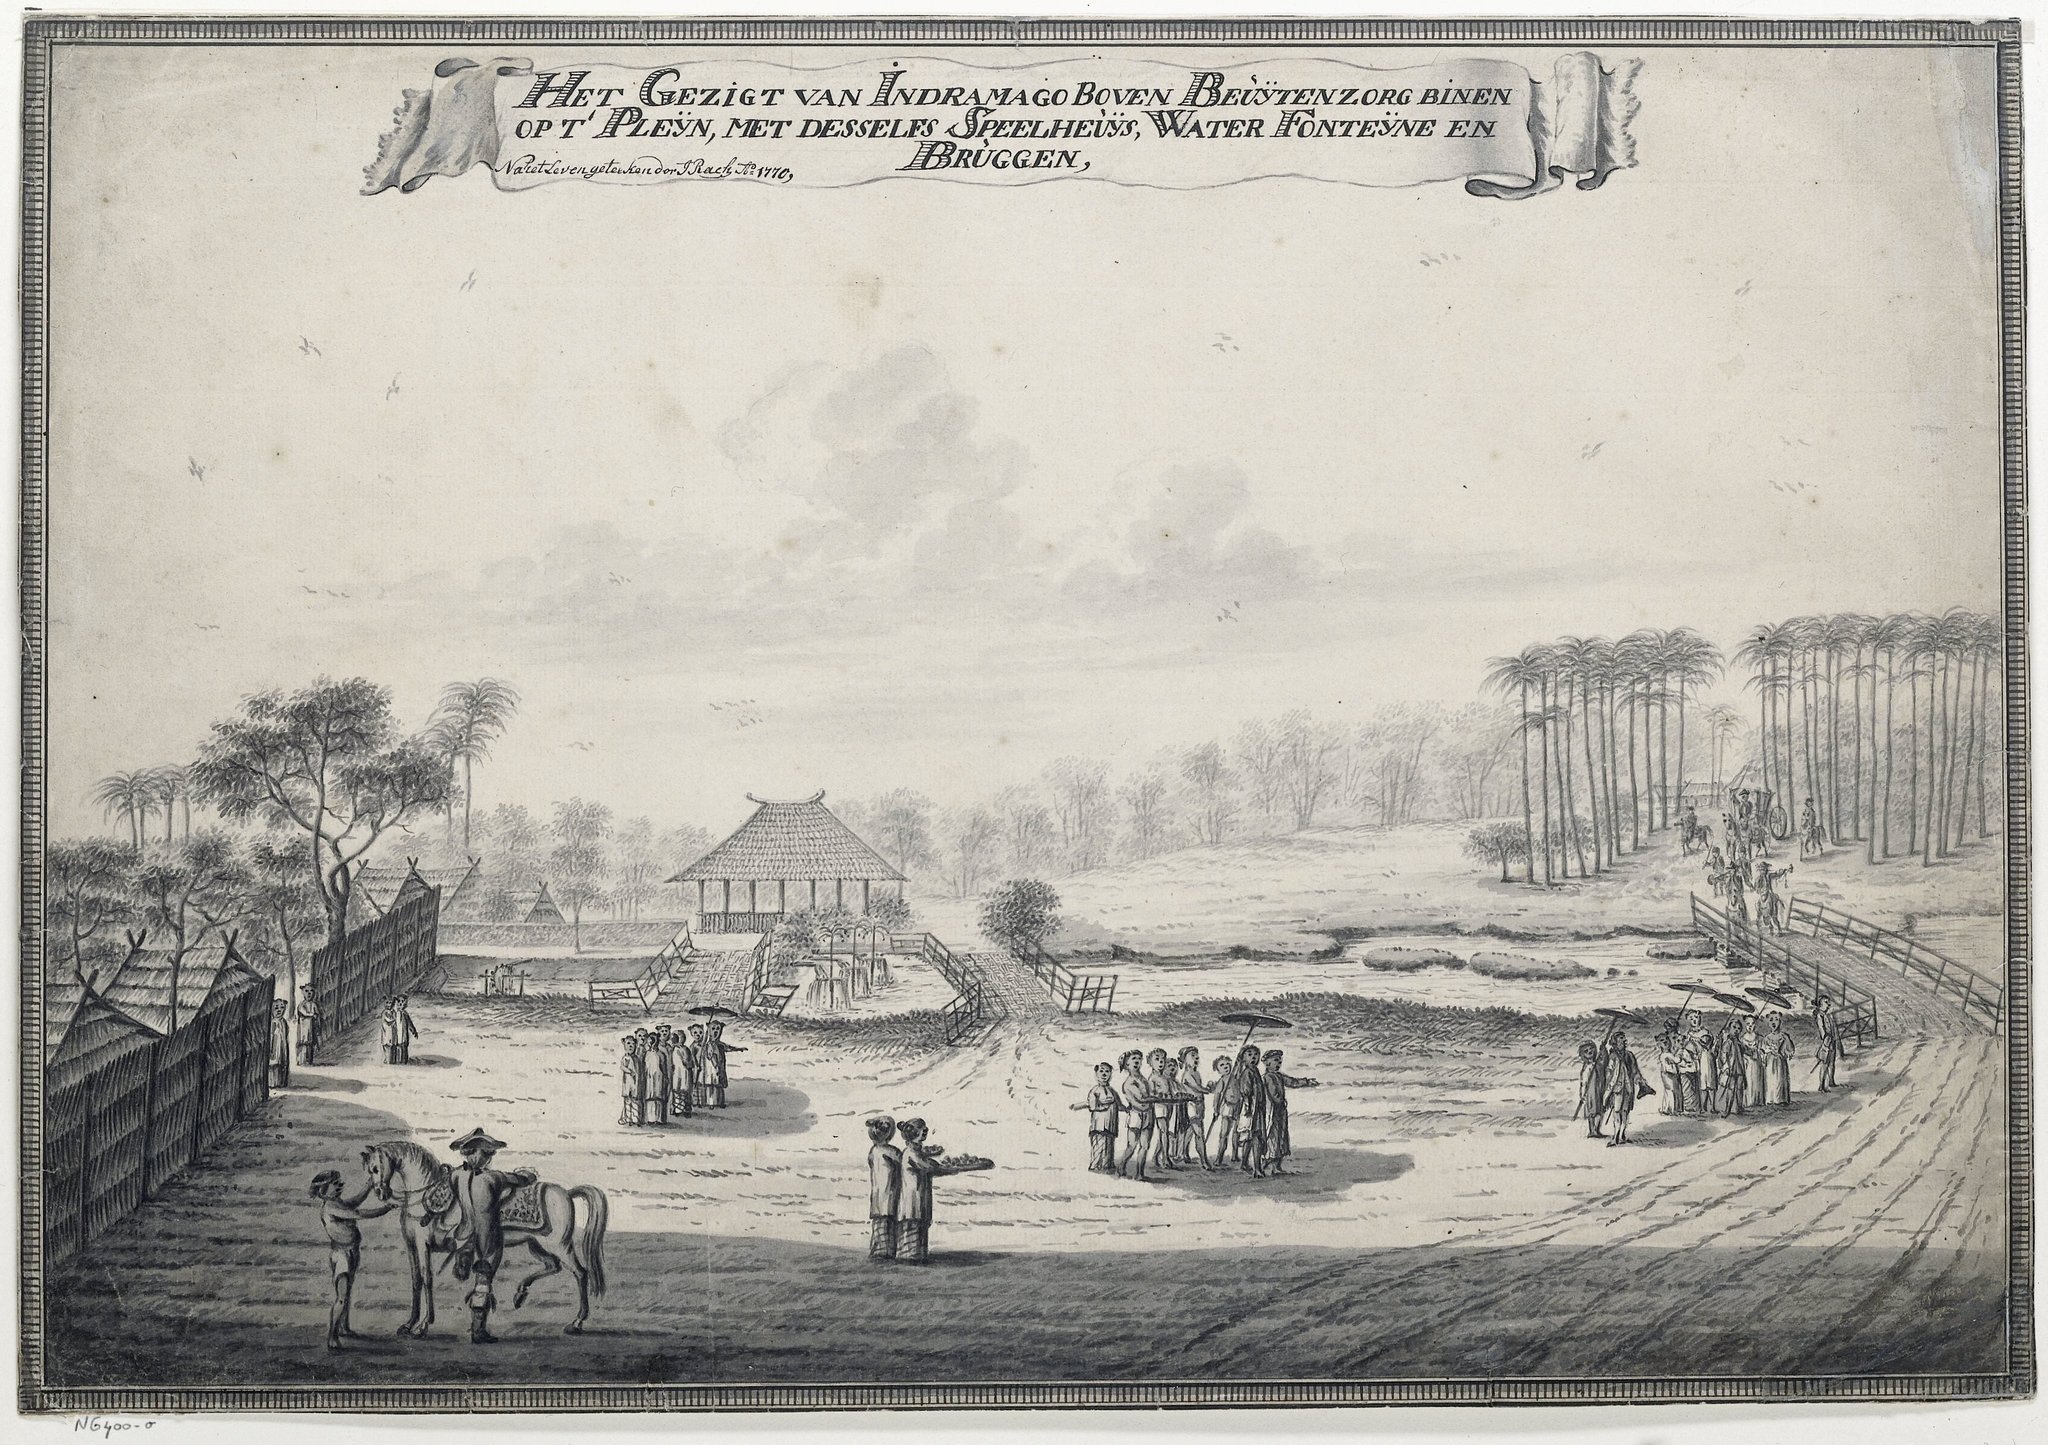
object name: drawing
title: Het Gezigt van Indramago boven Beuijtenzorg binen op t' Pleijn, met desselfs Speelheuijs, Water Fonteijne en Bruggen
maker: johannes rach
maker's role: draughtsman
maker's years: 1720-1783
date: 1770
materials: ink, paper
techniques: brush, pen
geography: buitenzorg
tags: river, landscapes in tropical and sub-tropical regions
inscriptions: date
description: Gezicht op Indramago bij Buitenzorg. Gezicht op een pleintje, linksonder een schutting met opening waarin enkele figuren, op de voorgrond man die paard bestijgt en vier groepjes figuren met parasollen. Achter het plein rivier met bruggen en fonteinen.